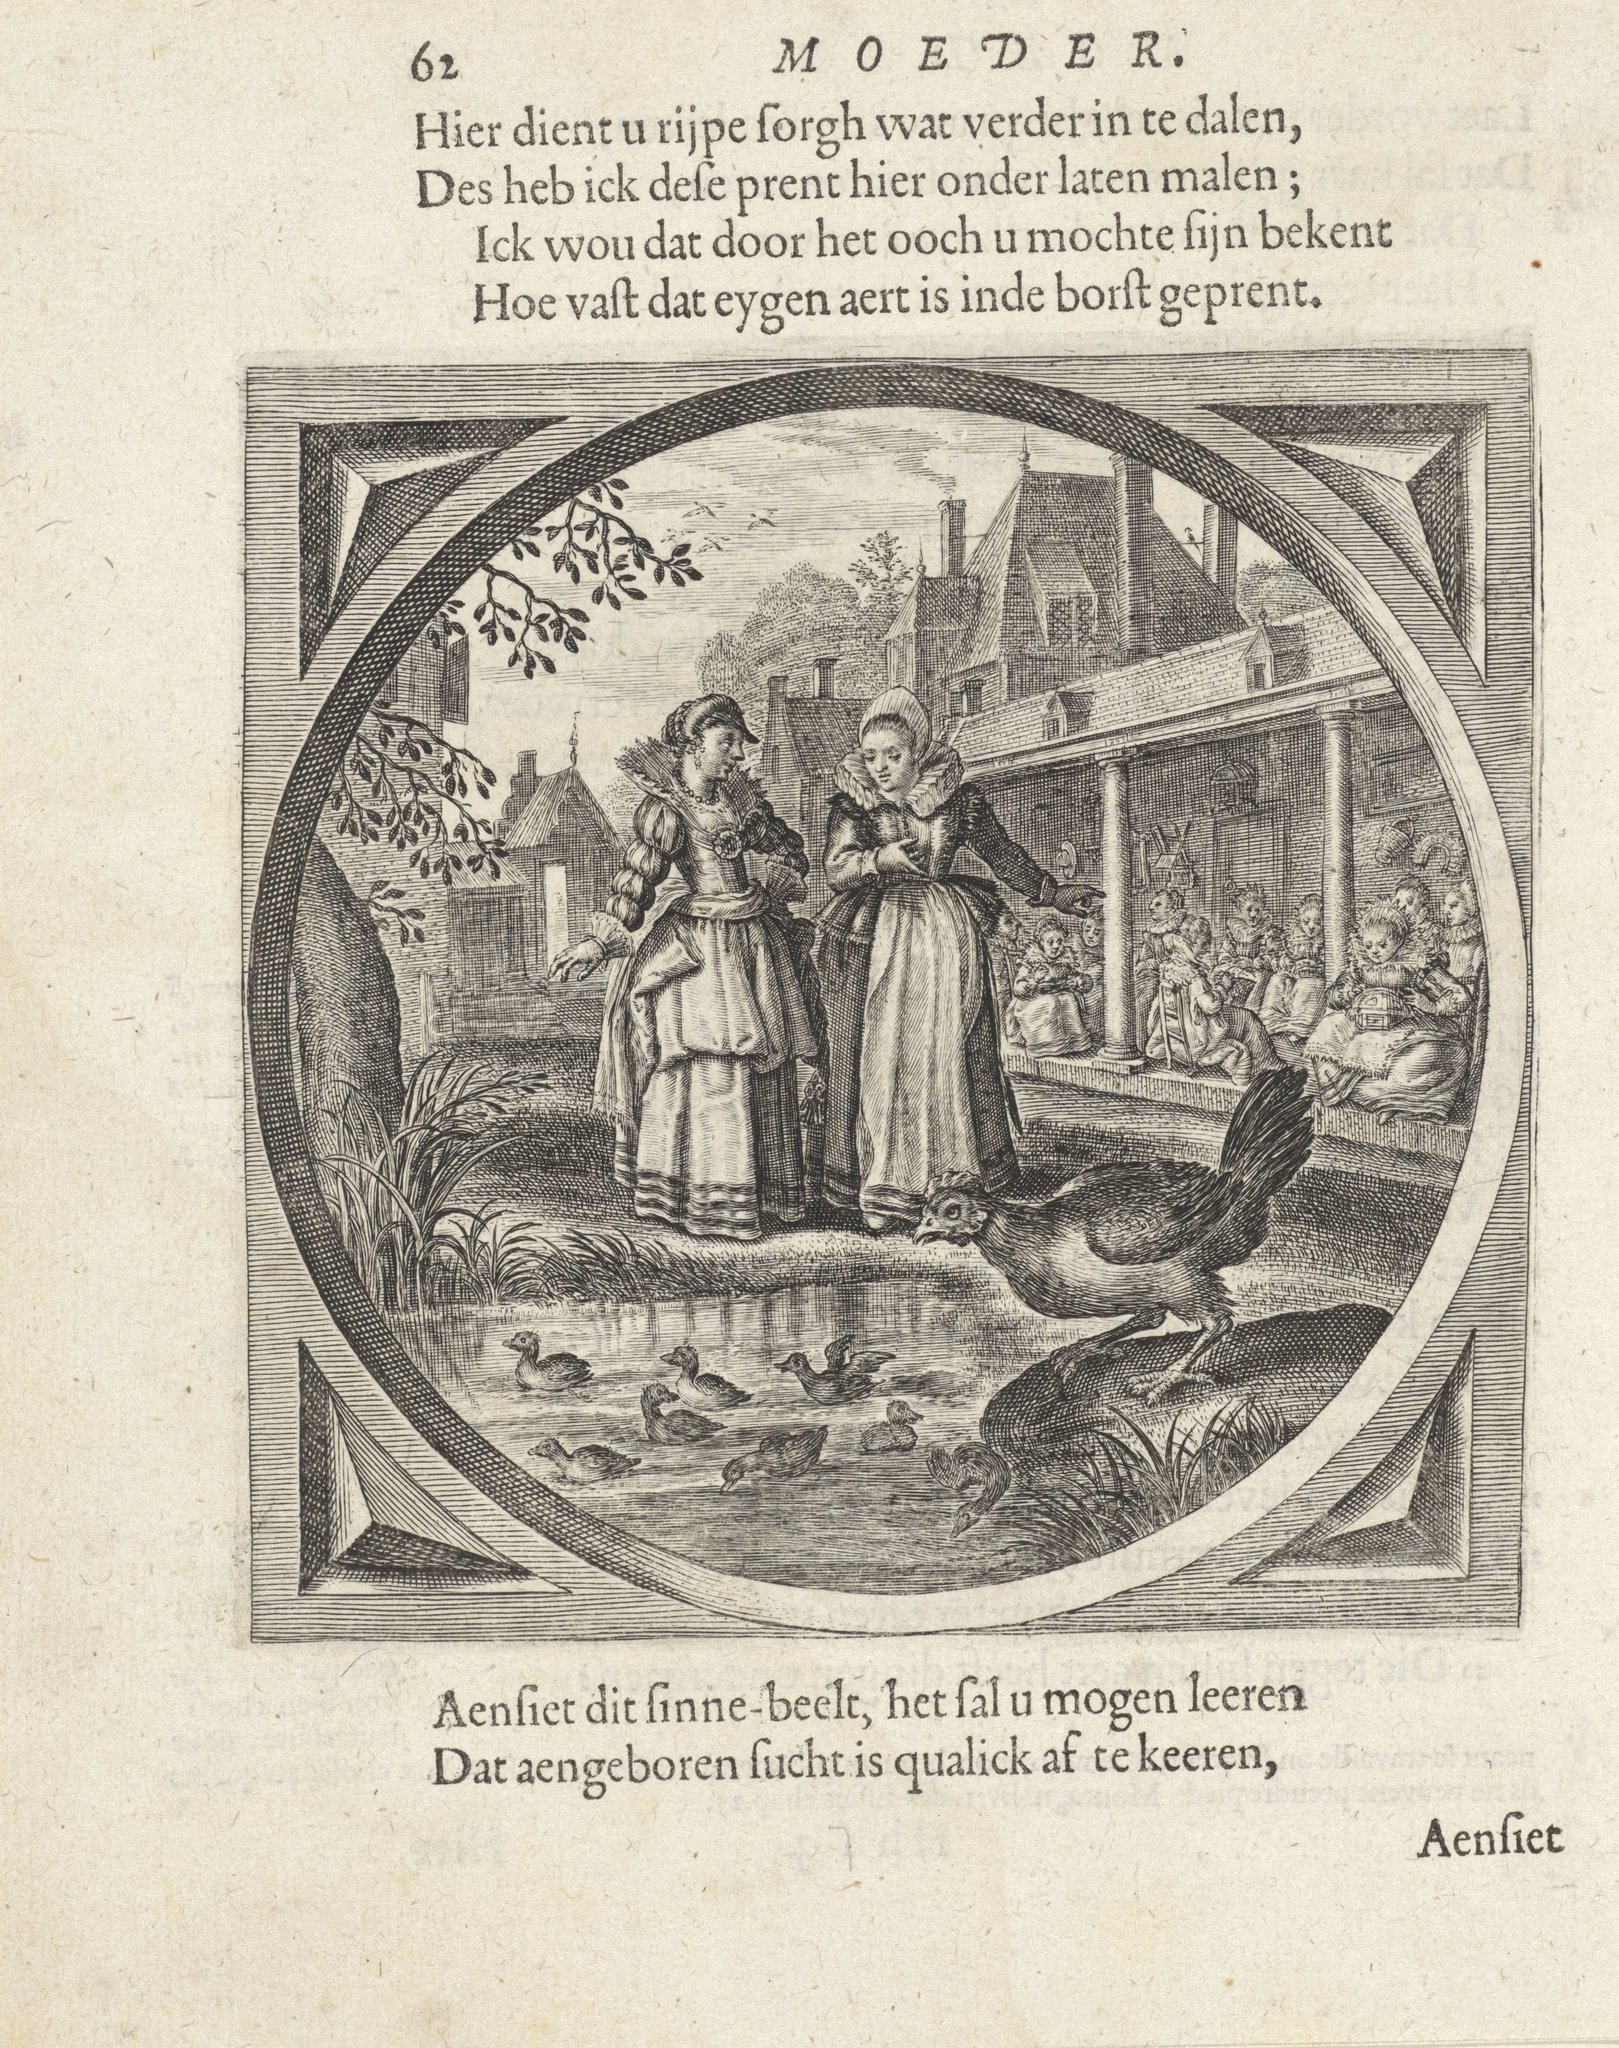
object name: book illustration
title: Twee vrouwen bij een kip met kuikens op het water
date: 1625-1635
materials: paper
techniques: engraving, letterpress printing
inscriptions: collector's mark: Lugt 2760, collector's mark: Lugt 2228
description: Boekillustratie in: Cats, Jacob. Hovwelyck. Dat is De gansche gelegentheyt des echten staets. Middelburg: Jan Pietersz van de Venne (wed.),1625-1626 en 's-Gravenhage: Adriaen van de Venne, 1625-1635.